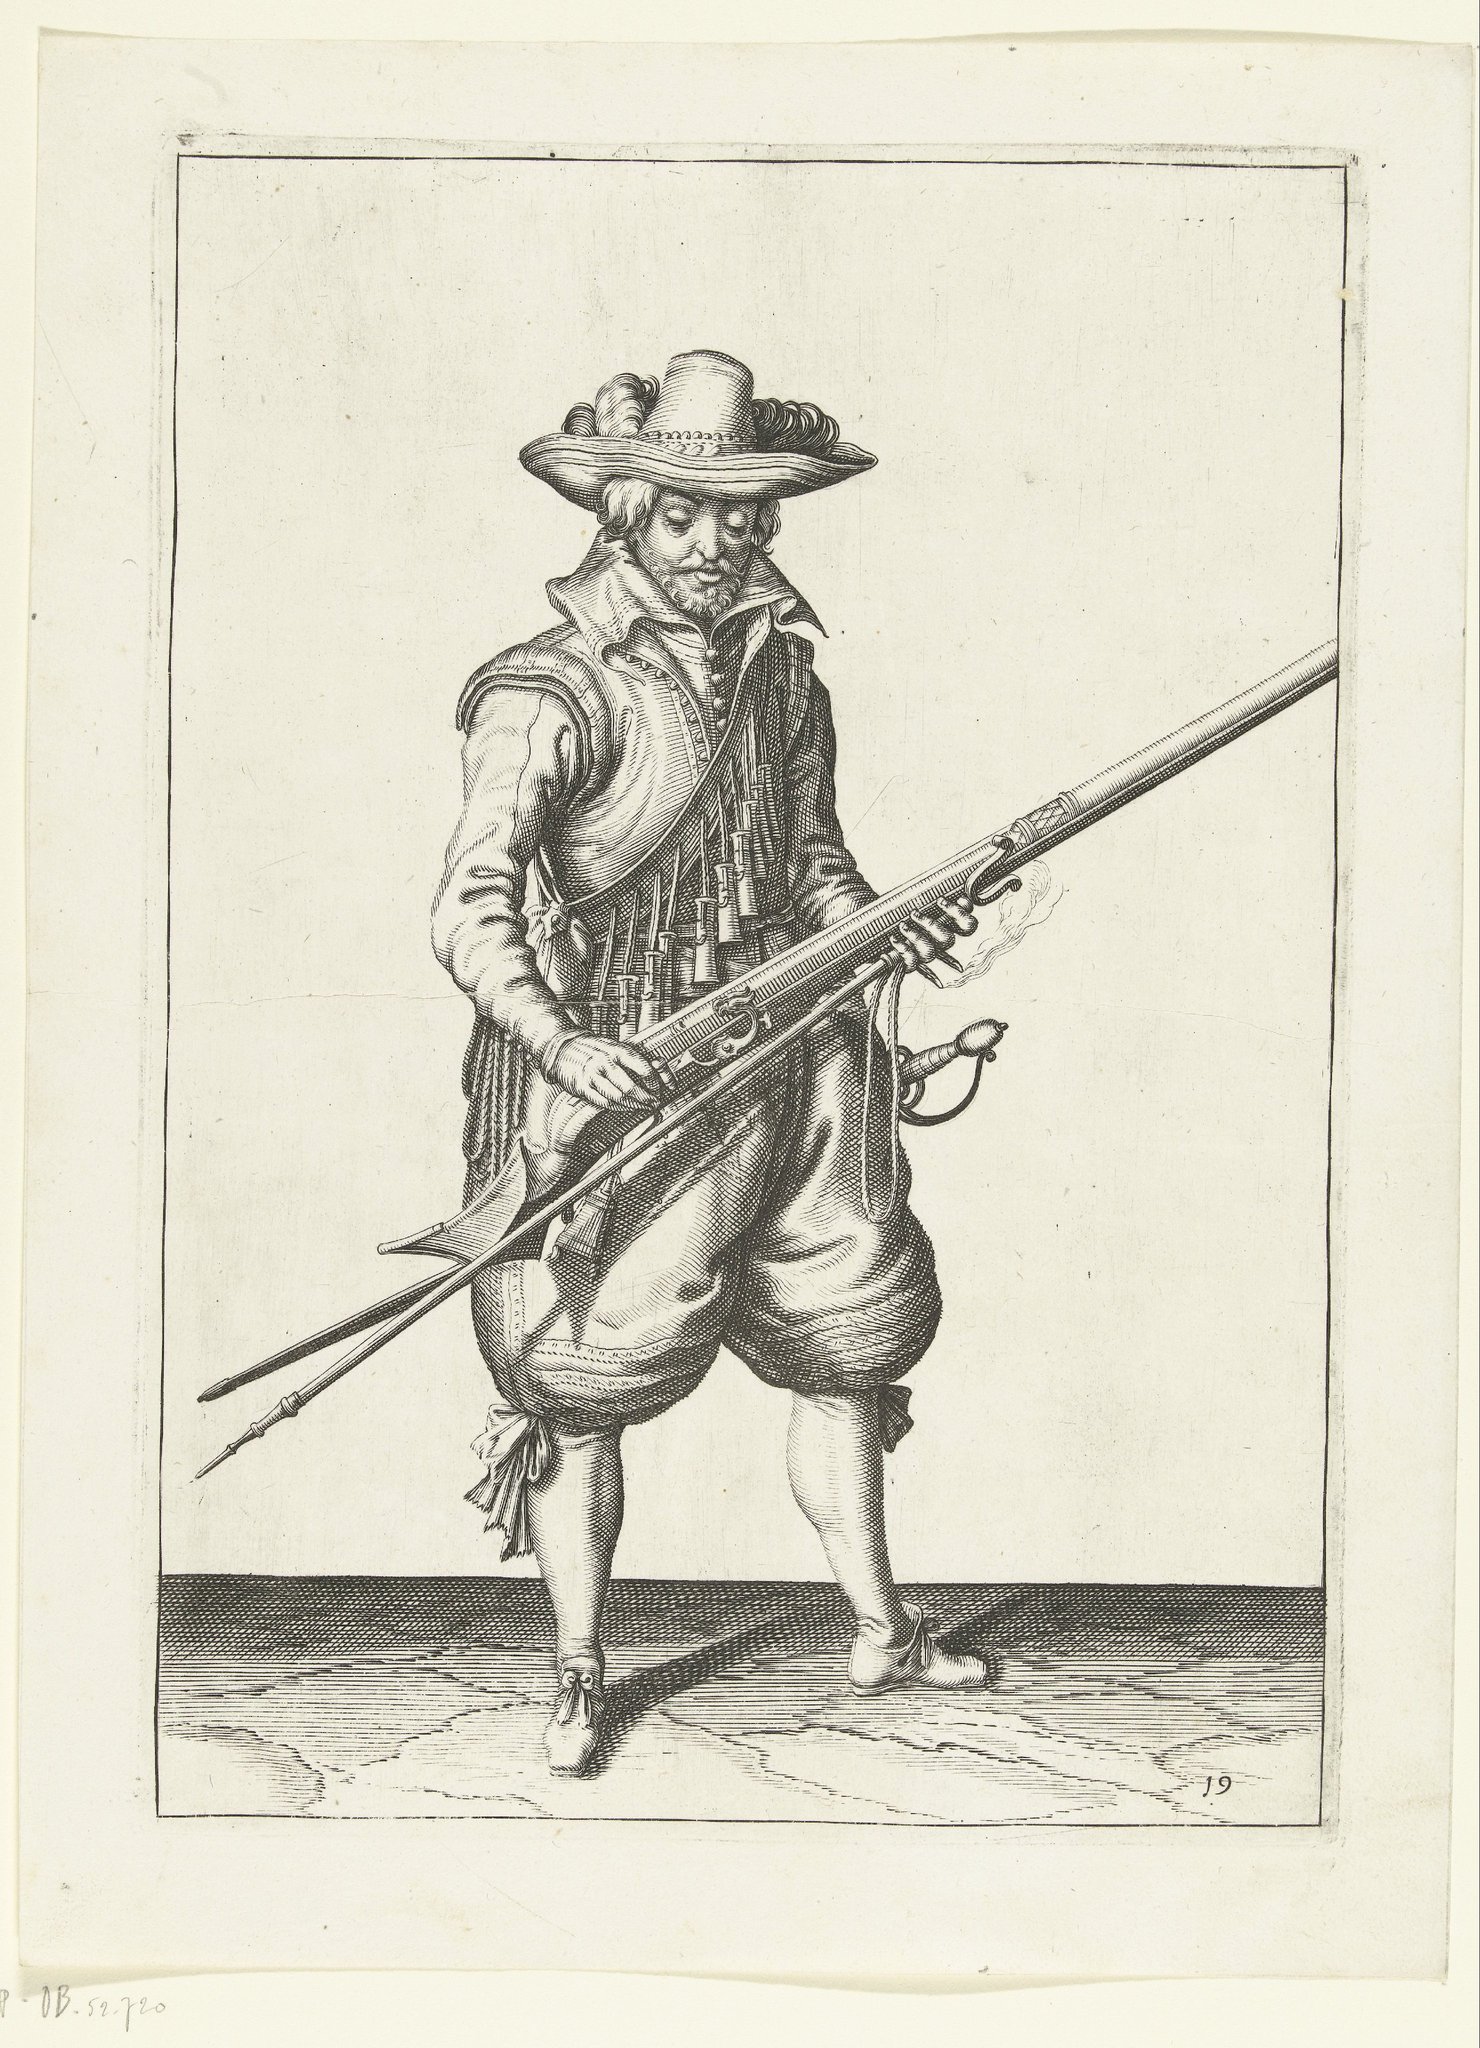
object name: print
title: Soldaat die kruit van zijn musket schudt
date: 1597-1607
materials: paper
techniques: engraving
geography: netherlands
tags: manoeuvre ~ military training, firearms: rifle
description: Een soldaat, ten voeten uit, naar rechts, die met beide handen een musket (een bepaald type vuurwapen) schudt, om eventueel buiten de pan (het kruitreservoir) gevallen kruit ervan af te krijgen. In zijn linkerhand behalve de loop van het musket ook een furket (musketvork) en een brandende lont. Deze prent is onderdeel van de reeks van 43 genummerde prenten van musketiers uit de Wapenhandelinghe.